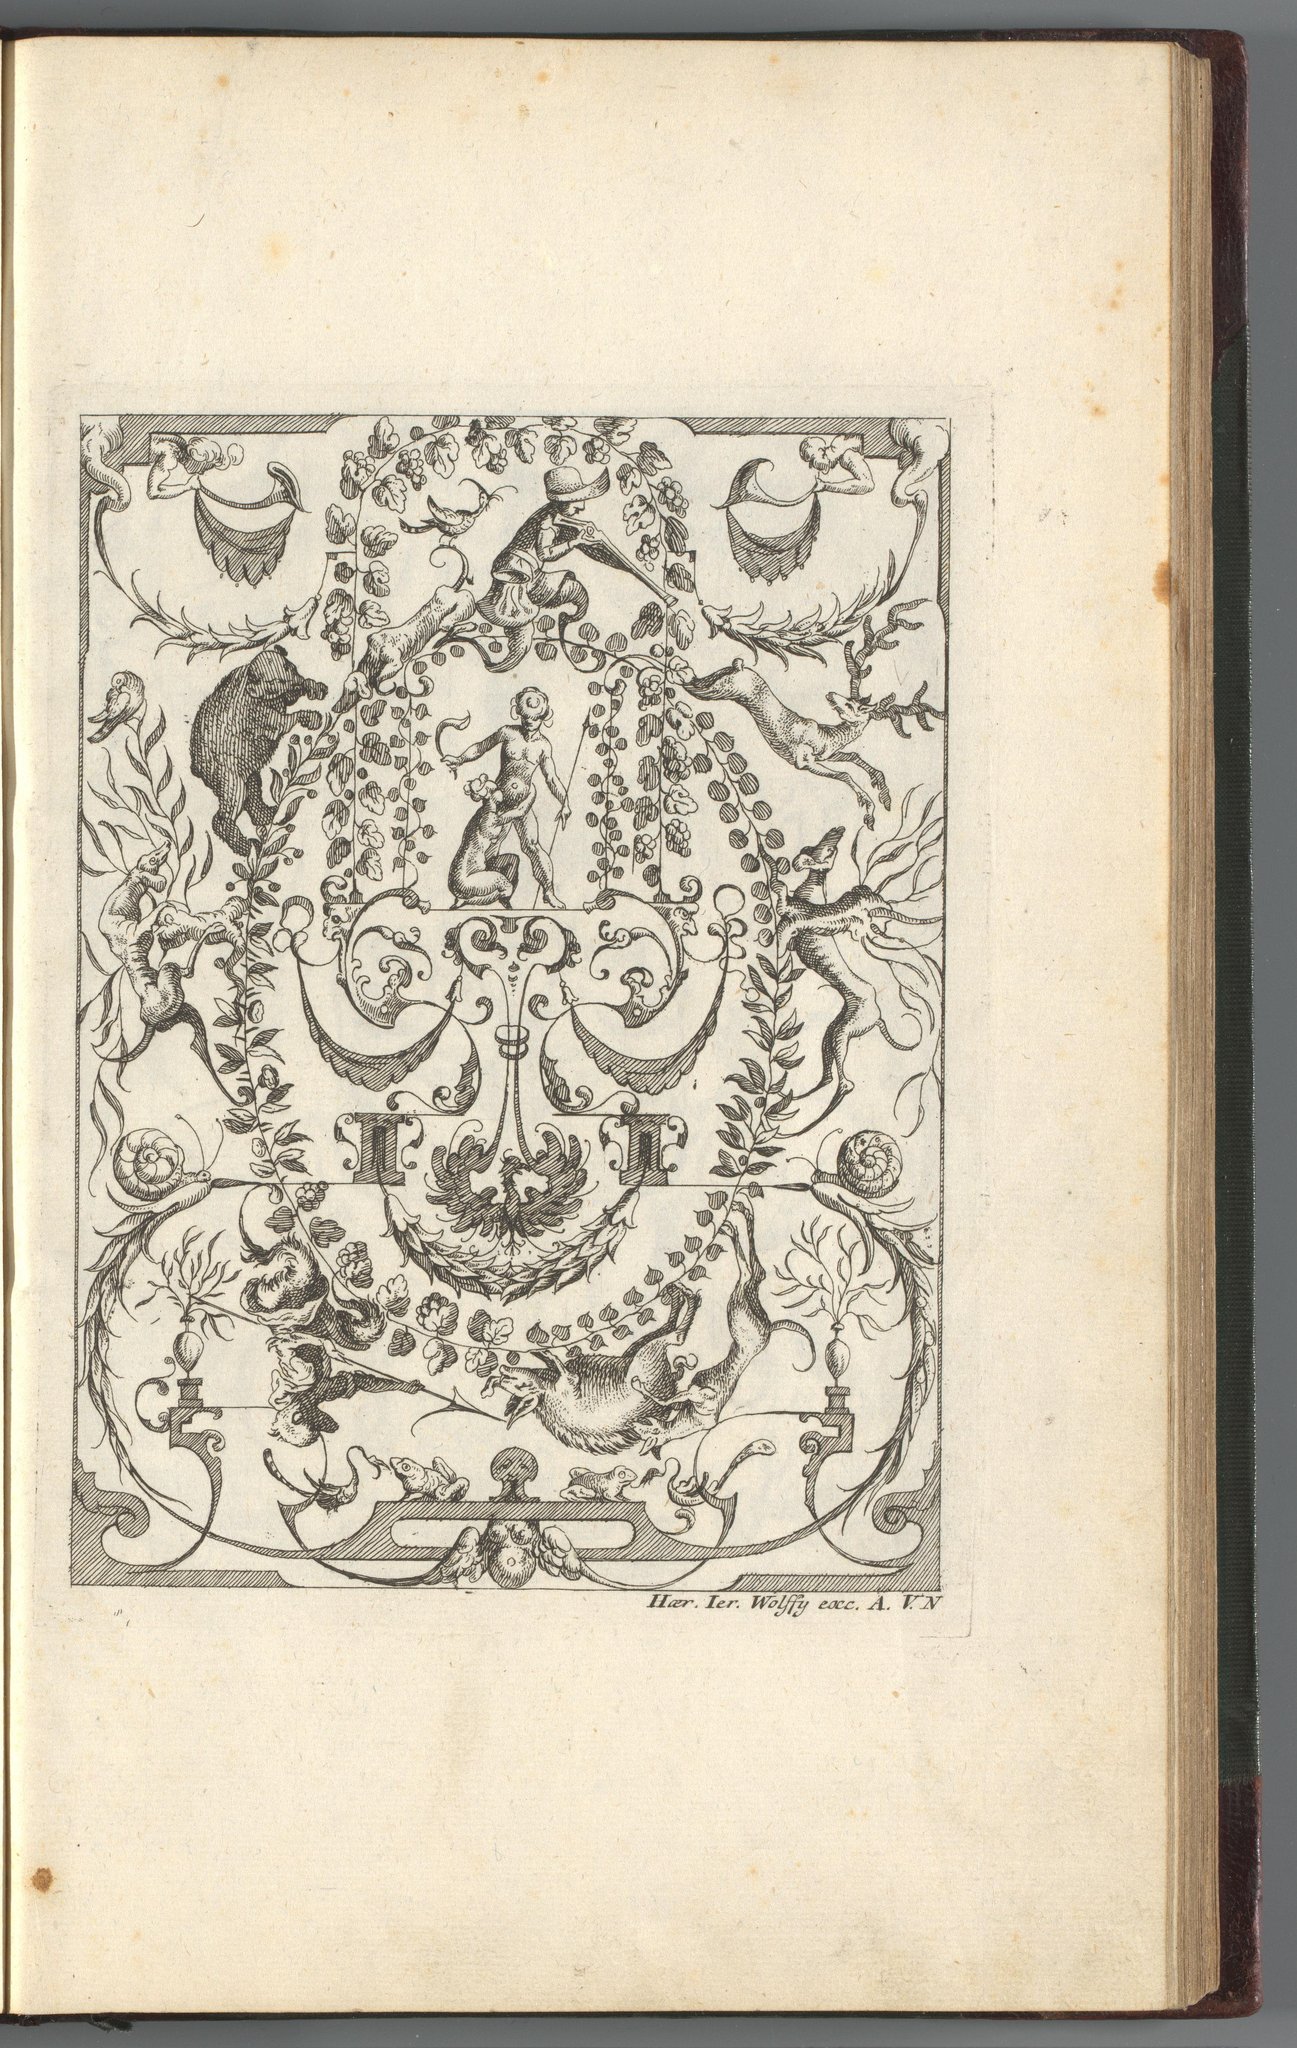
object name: ornament print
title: Compositie met een aanbiddende vrouw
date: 1686-1724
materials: paper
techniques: etching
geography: augsburg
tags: ornaments ~ art, hunters hunting (n.b.: in 1988-1990 this notation denoted the concept of 43c11421 'hunters resting during the hunt')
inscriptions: signature: ‘Ier. Wolffij exc. A. V. N.’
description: Een decoratieve compositie met vlechtwerk met in het midden een vrouw aanbiddend voor een man met een hoorn, misschien Circe en Picus. Zij worden omringd door een scène van twee jagers van dieren, een met een geweer en een met een speer. Prent maakt deel uit van een album. Hoogstwaarschijnlijk gespiegelde kopie naar Frans origineel.